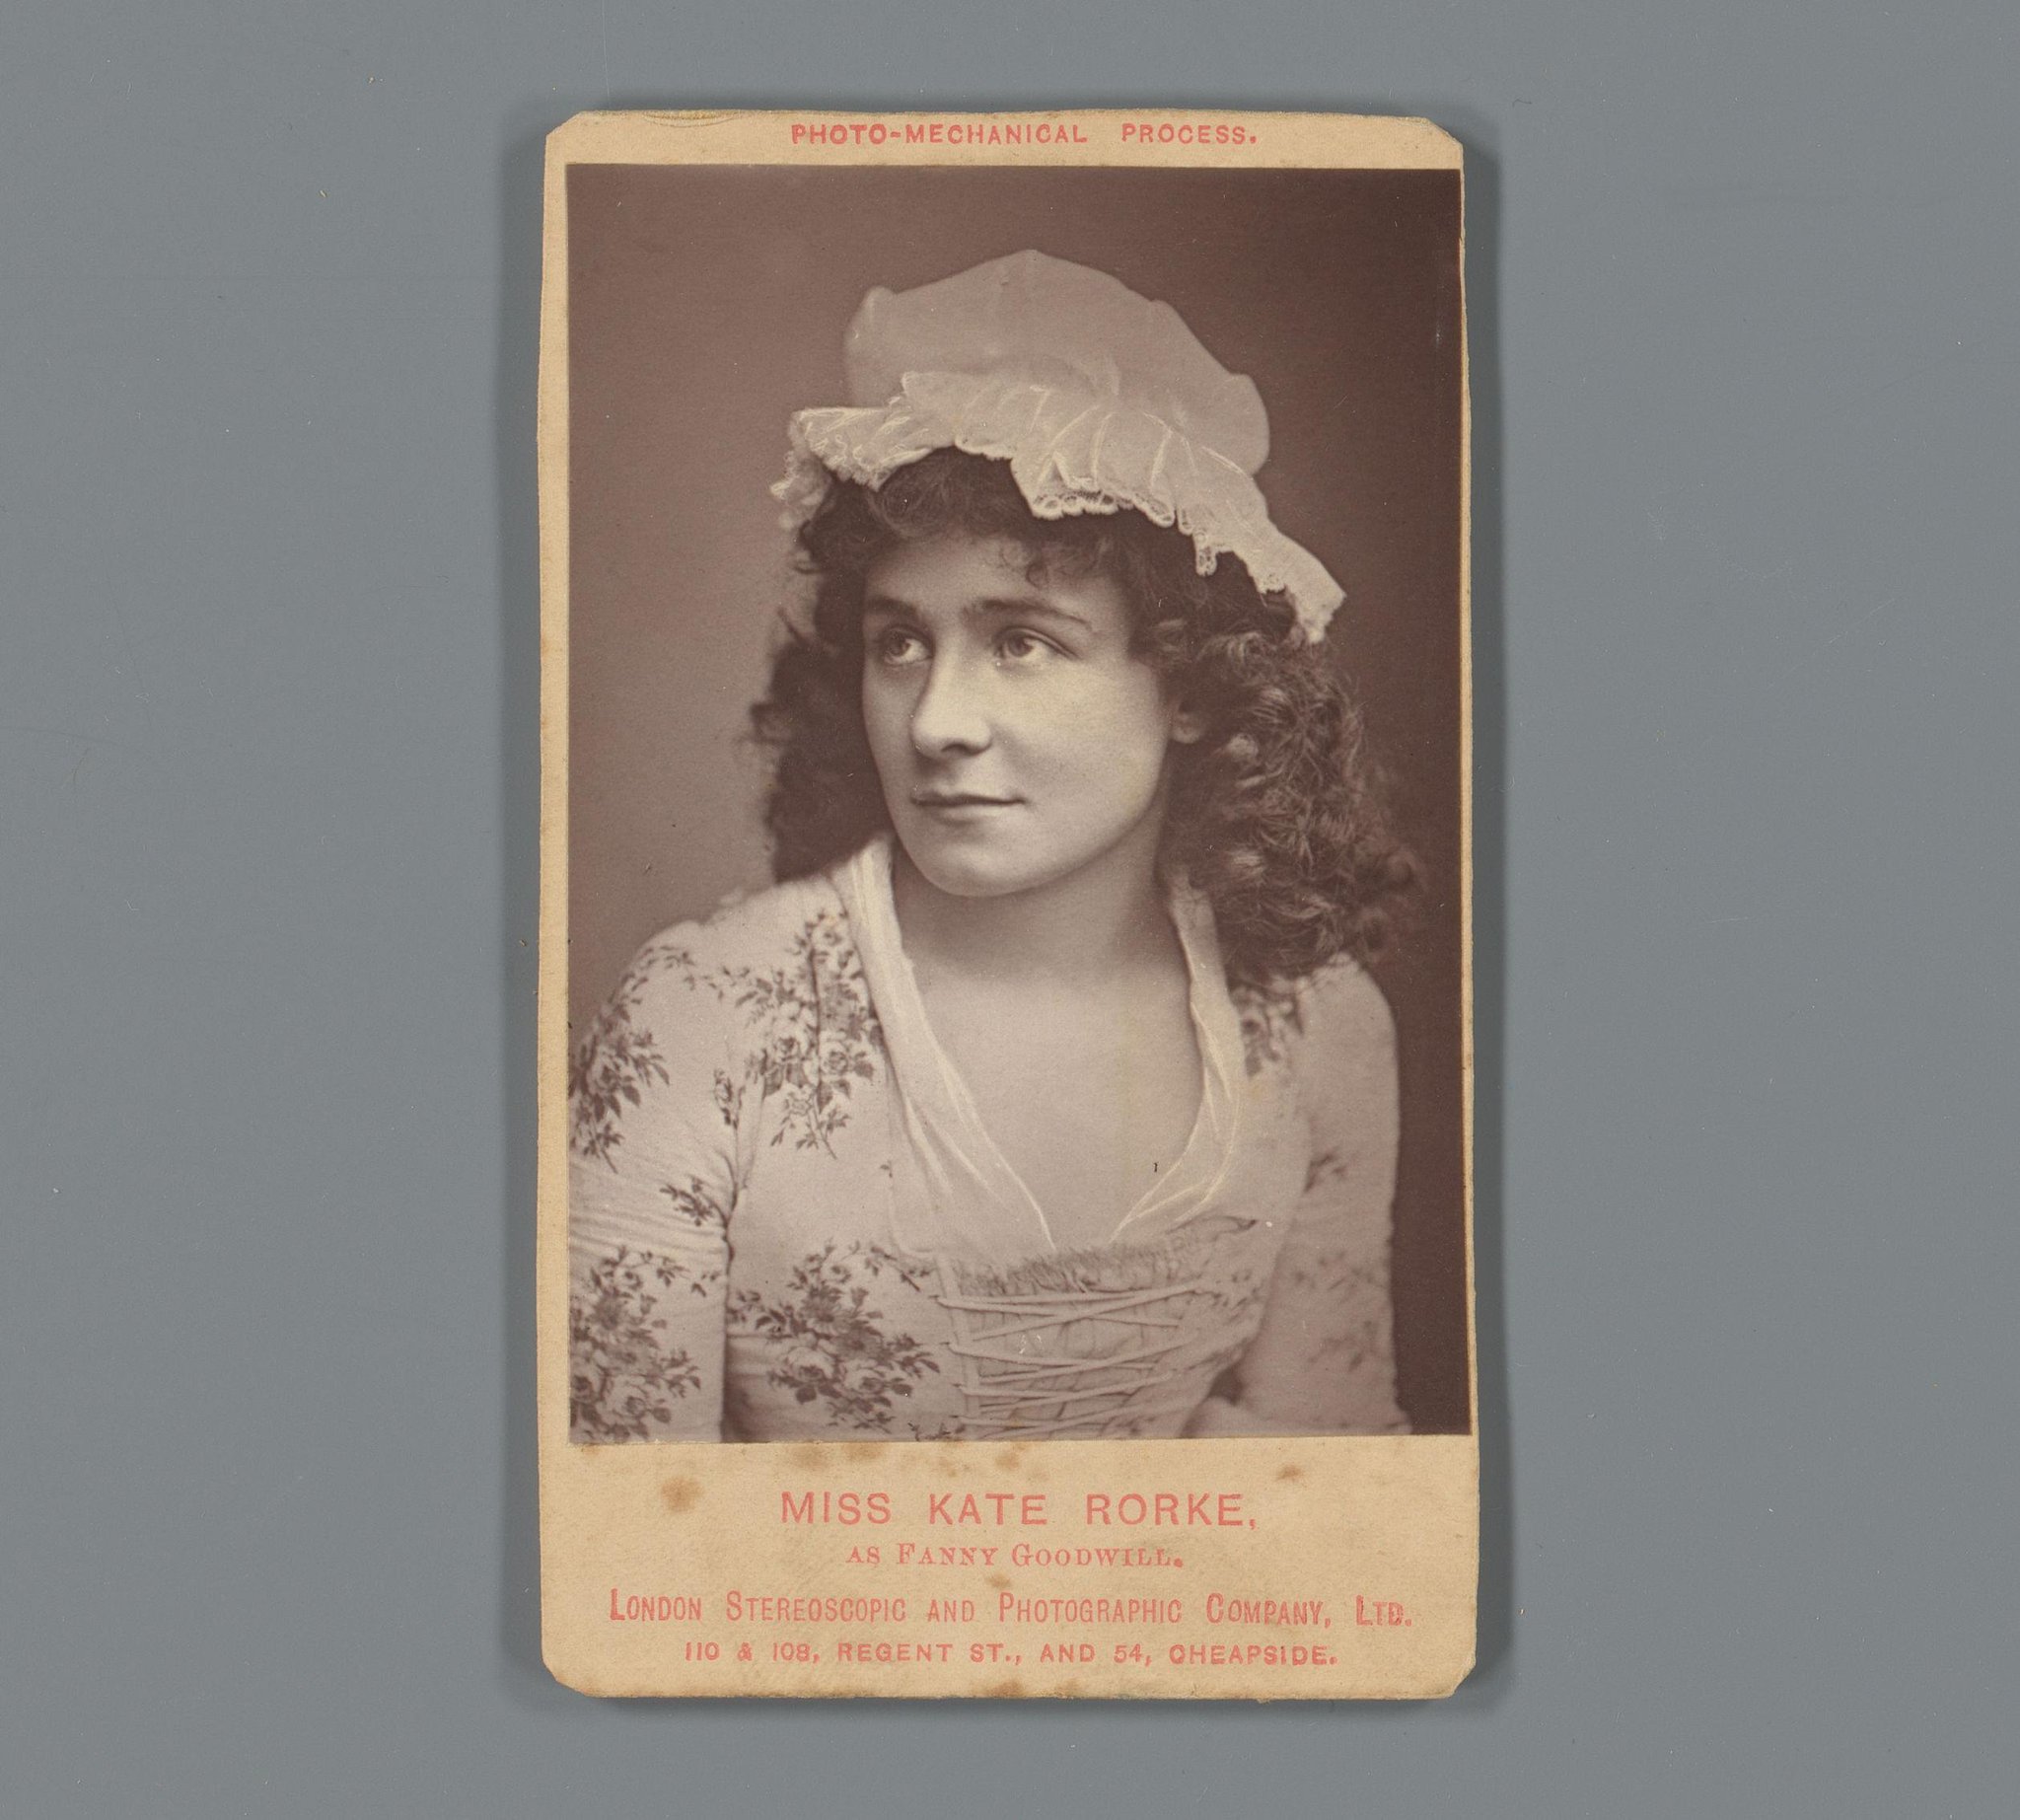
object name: carte de visite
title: Miss Kate Rorke as Fanny Goodwill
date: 1870-1900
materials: cardboard, photographic support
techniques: woodburytype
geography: london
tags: advertising, stage costume, historical persons - bb - woman, portrait of actor, actress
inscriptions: inscription: ‘PHOTO-MECHANICAL PROCESS./ London Stereoscopic & Photographic., Ltd./ 106 & 108, REGENT ST., AND 54, CHEAPSIDE.’, inscription: ‘VAUDEVILLE THEATRE./ Sole Lessee and Manager - Mr. THOMAS THORNE./ Every Evening at 8 o'clock, Joseph's Sweetheart,/ By ROBERT BUCHANAN./ (...)/ Acting Manager - Mr. SYDNEY ALPORT.’